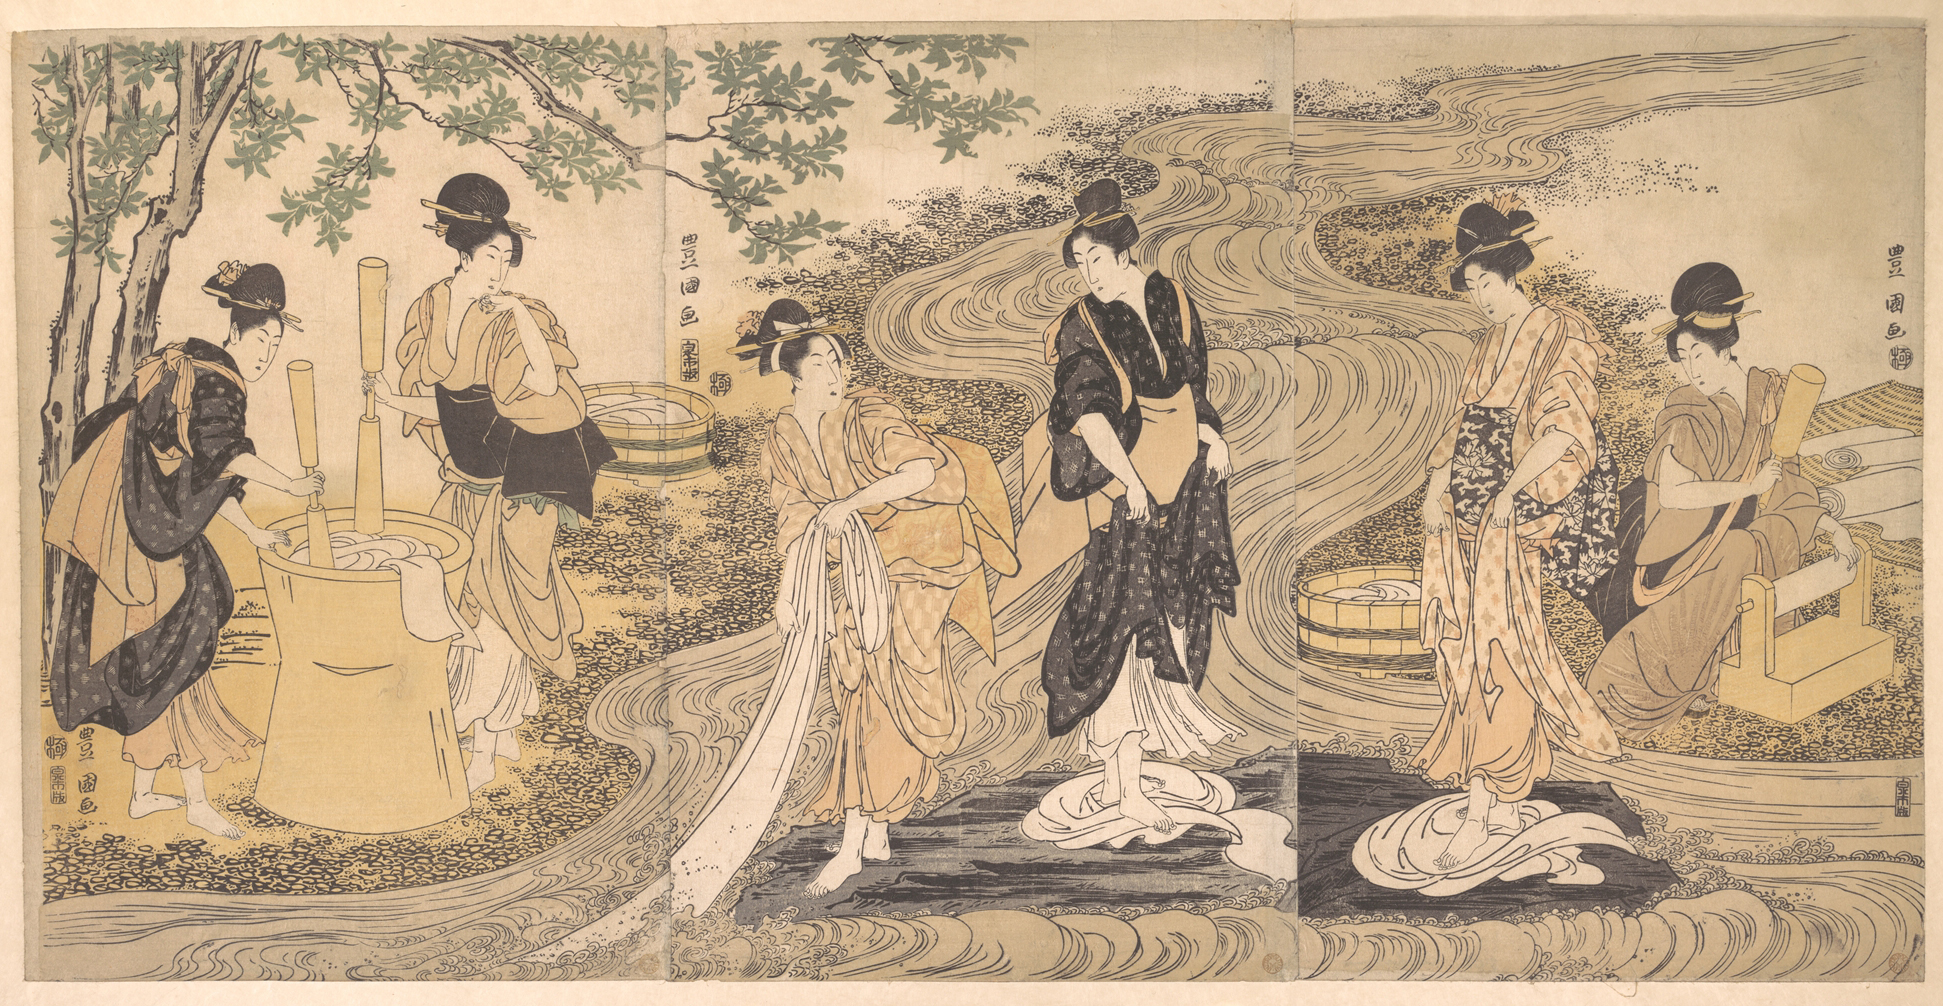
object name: woodblock print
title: Tetsukuri no Tamagawa on the Musashino Plain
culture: japanese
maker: utagawa toyokuni i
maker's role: artist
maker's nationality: japanese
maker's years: 1769-1825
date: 1800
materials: ink, paper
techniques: woodblock print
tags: women,rivers,washing,working